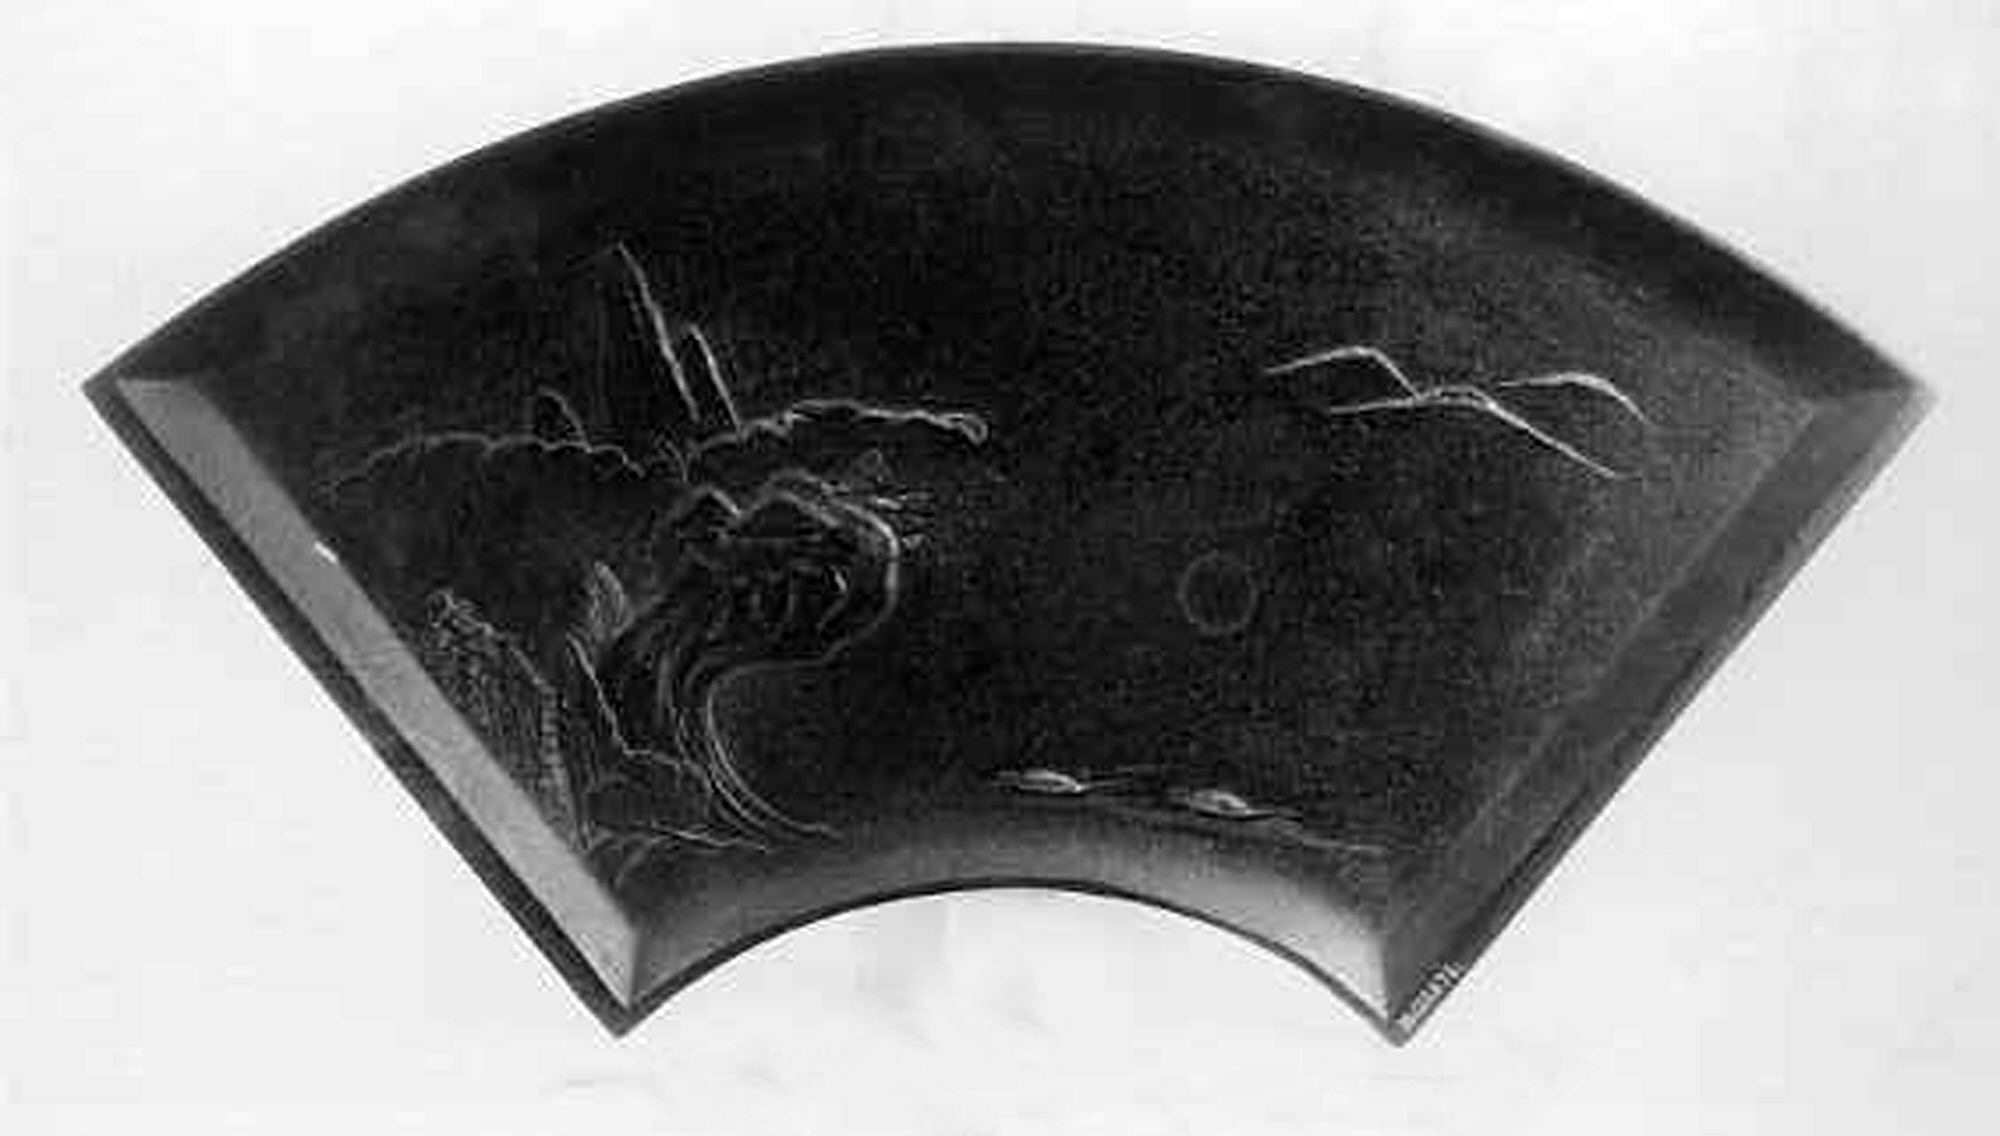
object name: tray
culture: japanese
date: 1801-1833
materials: iron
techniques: hammering